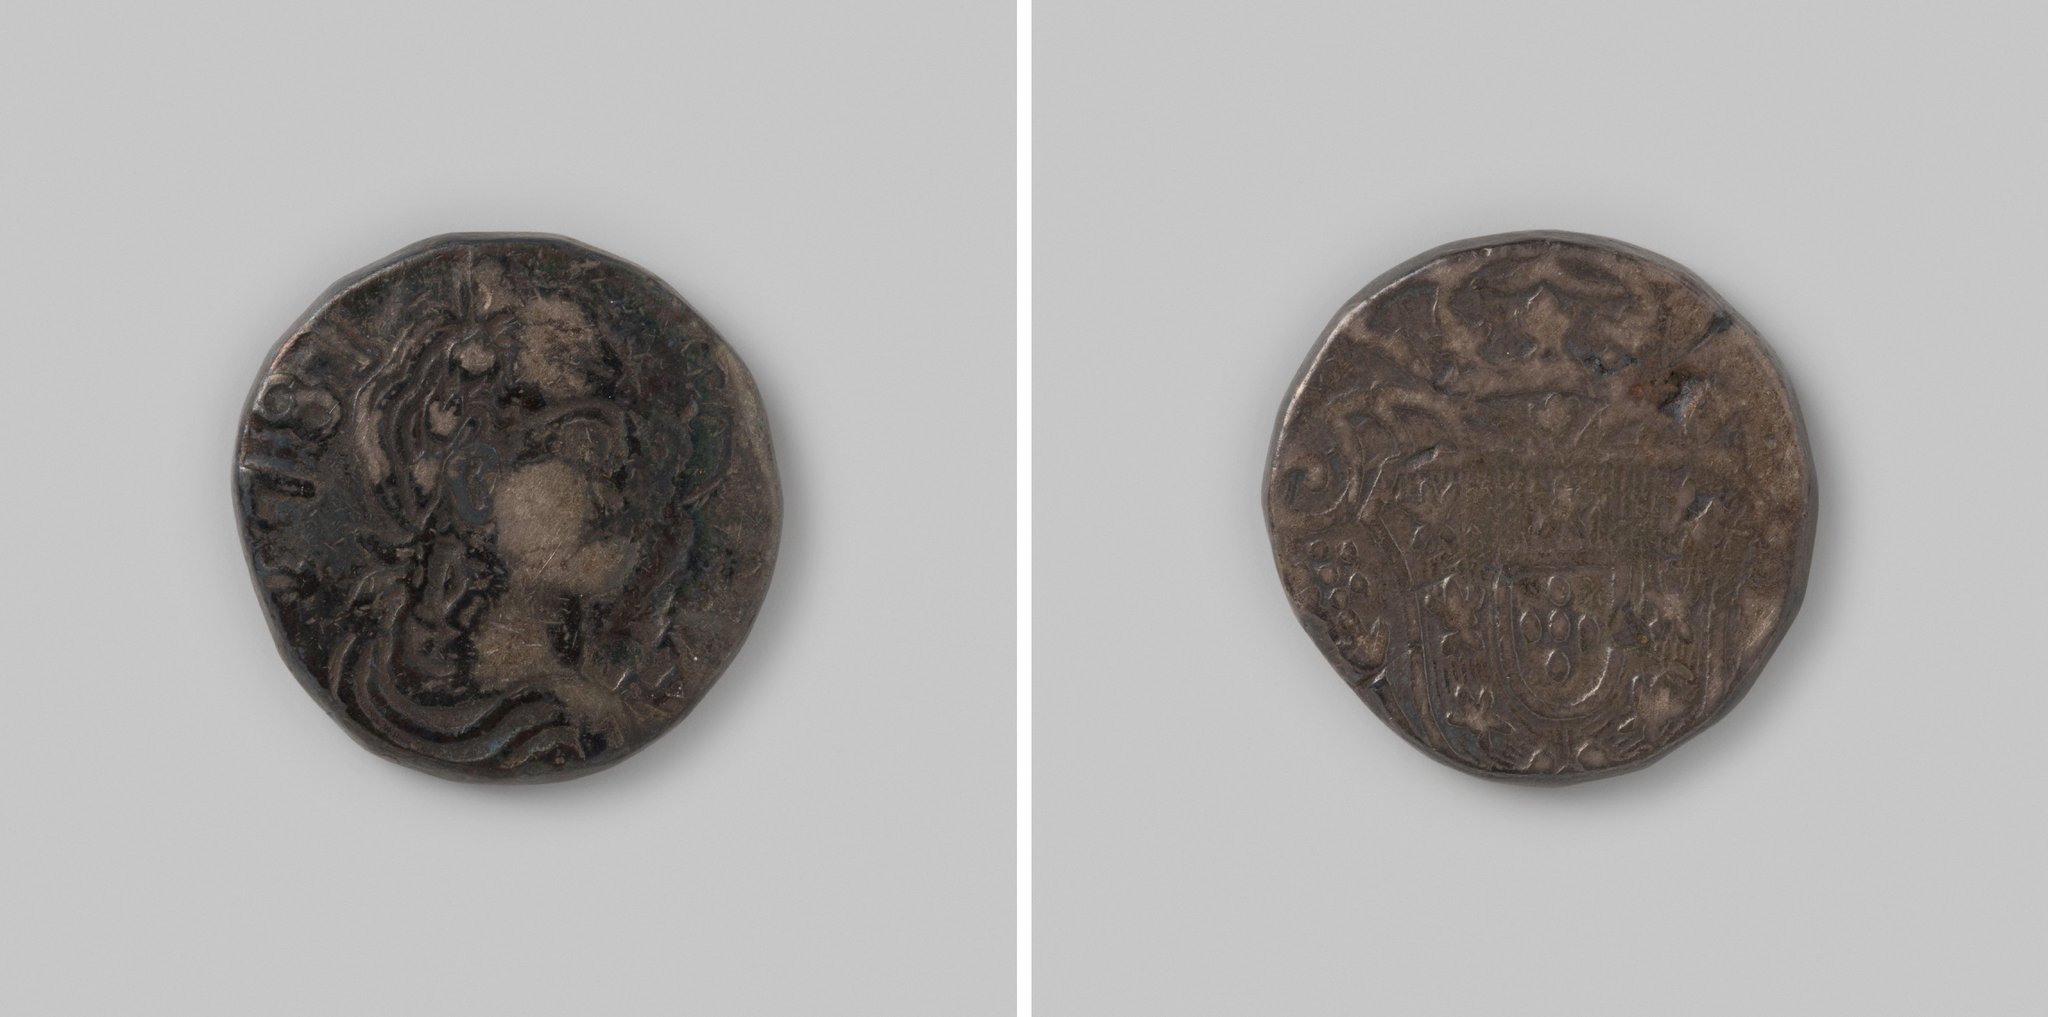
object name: coin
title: Rupia of 2 pardaos uit Goa, Portugees India van koningin Maria I, 1781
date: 1781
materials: silver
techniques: striking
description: Zilveren munt. Voorzijde: hoofd naar rechts. Als omschrift jaartal en waarde-aanduiding: rvpia. Keerzijde: gekroond versierd wapenschild van Portugal. Gladde rand.